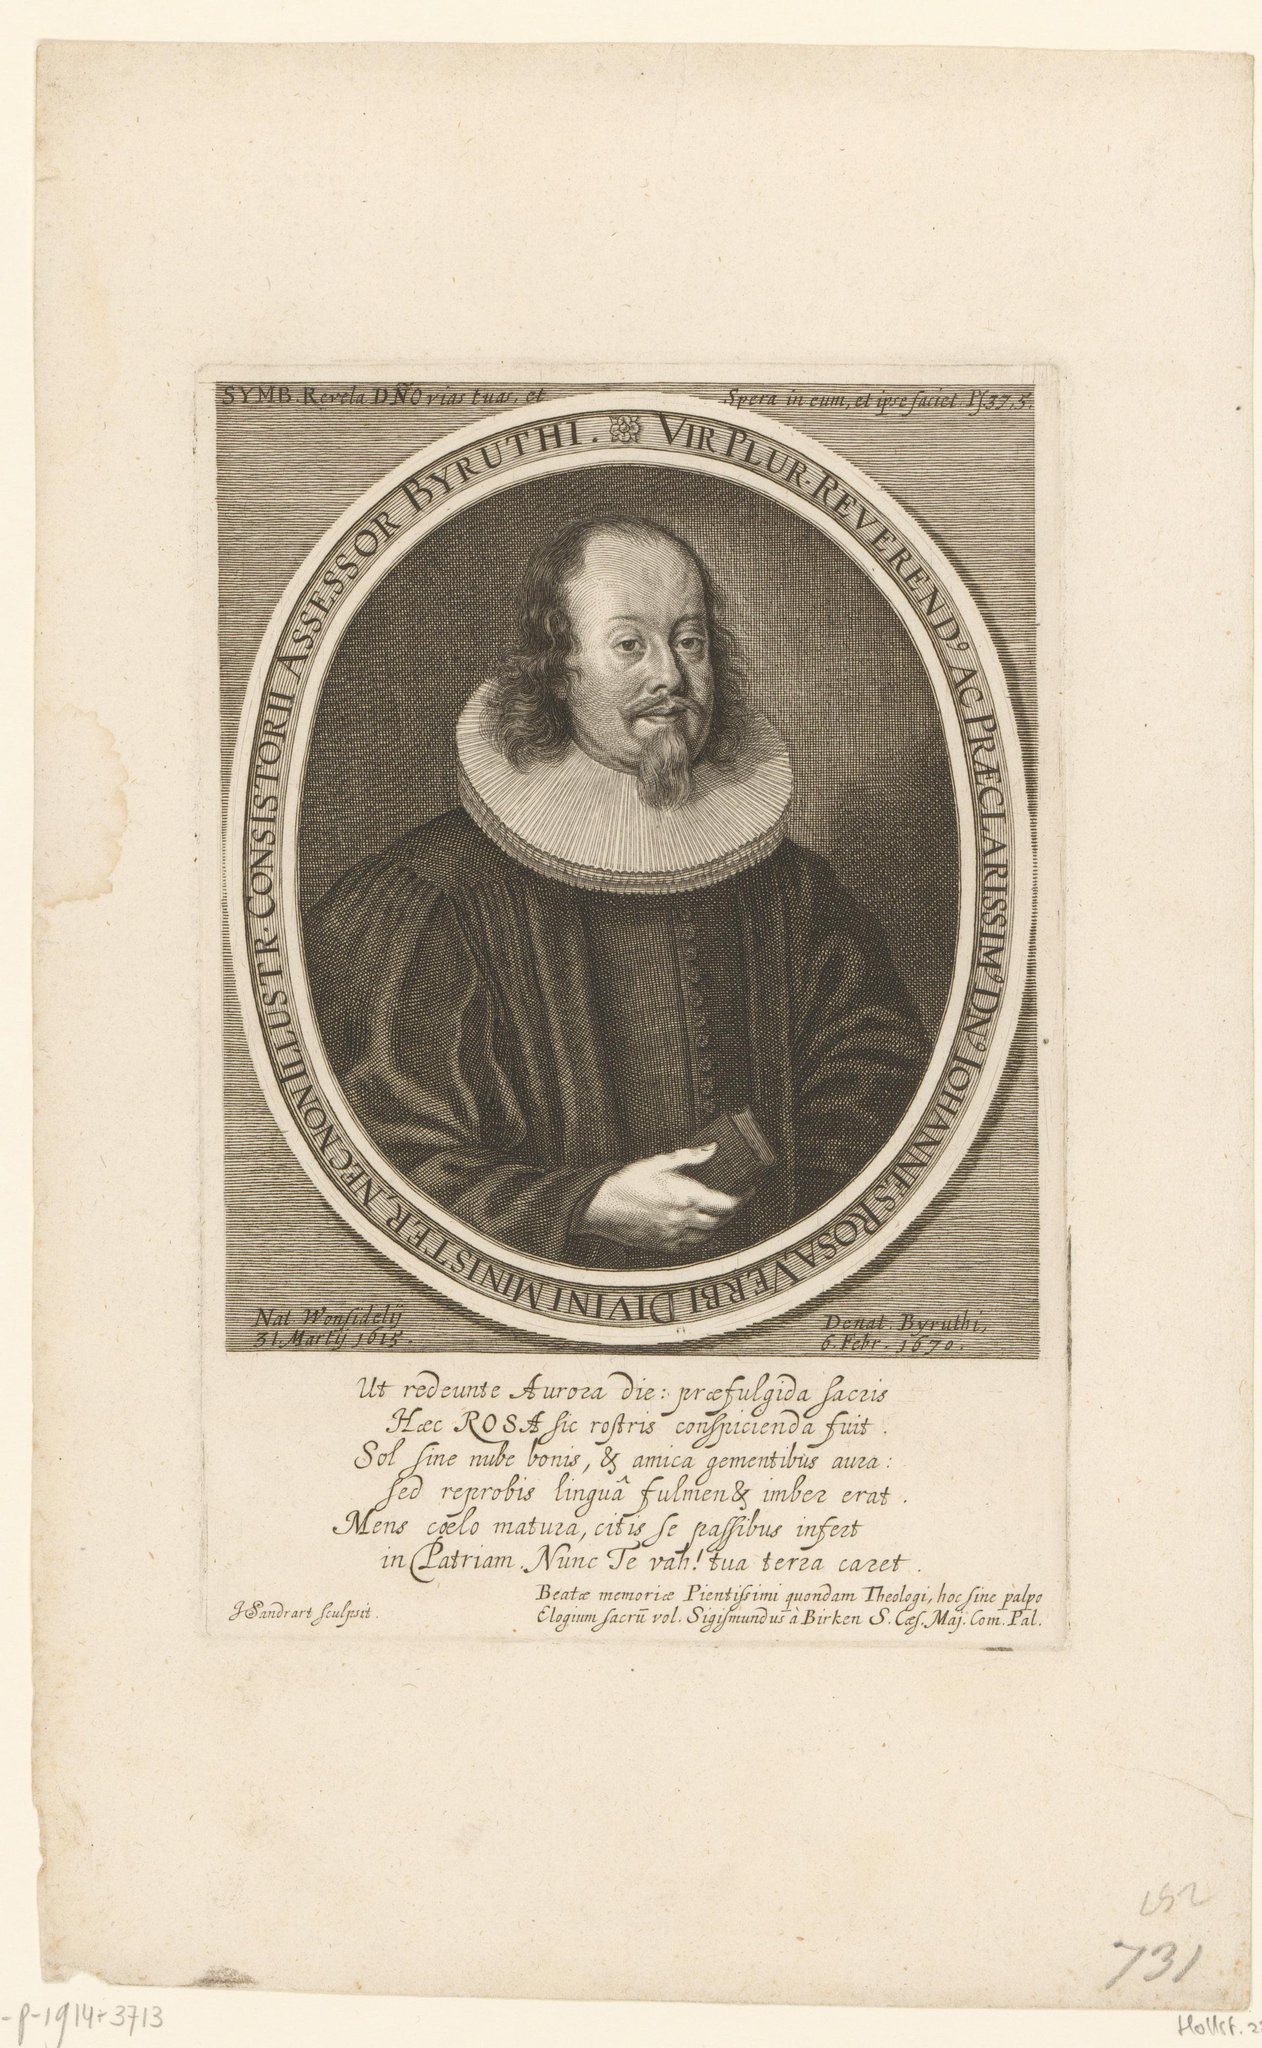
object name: print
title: Portret van Johannes Rosa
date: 1670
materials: paper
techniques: engraving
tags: amberg, historical persons, book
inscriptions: collector's mark: Lugt 2228